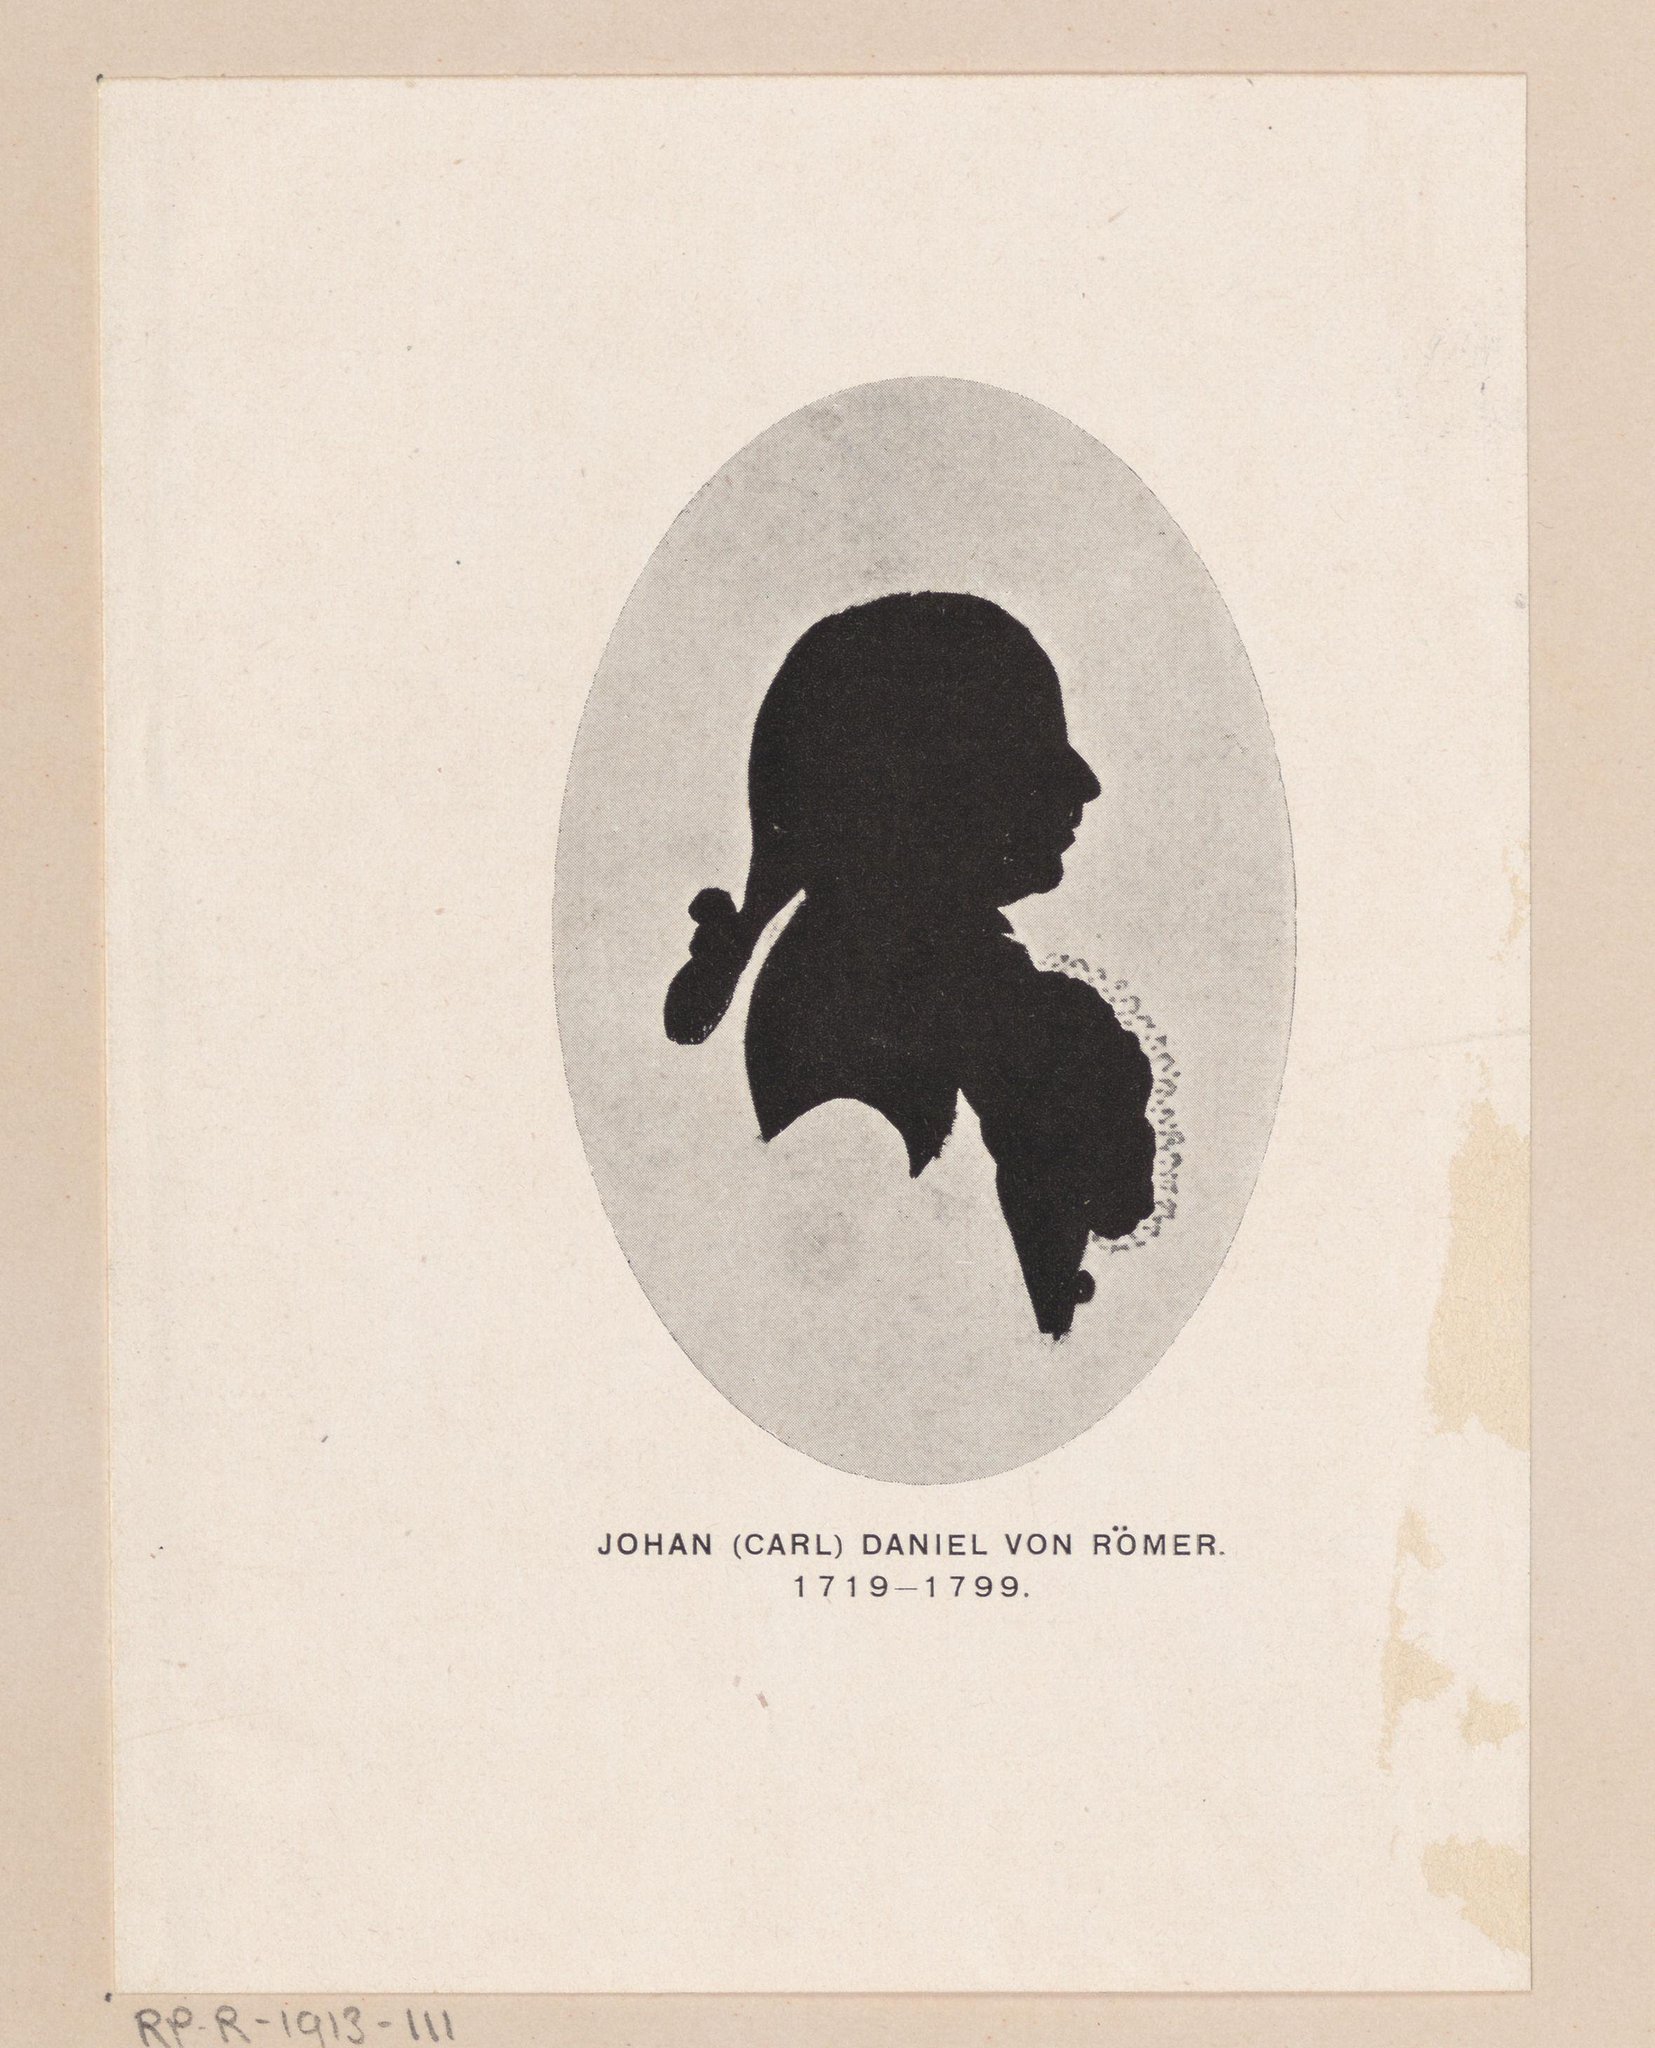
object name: photomechanical print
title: Portret van Johan Daniel von Römer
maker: Anonymous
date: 1913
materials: paper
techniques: letterpress printing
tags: historical persons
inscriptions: collector's mark: Lugt 2228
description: Prent mogelijk uit: Nederland's Patriciaat, 1913.